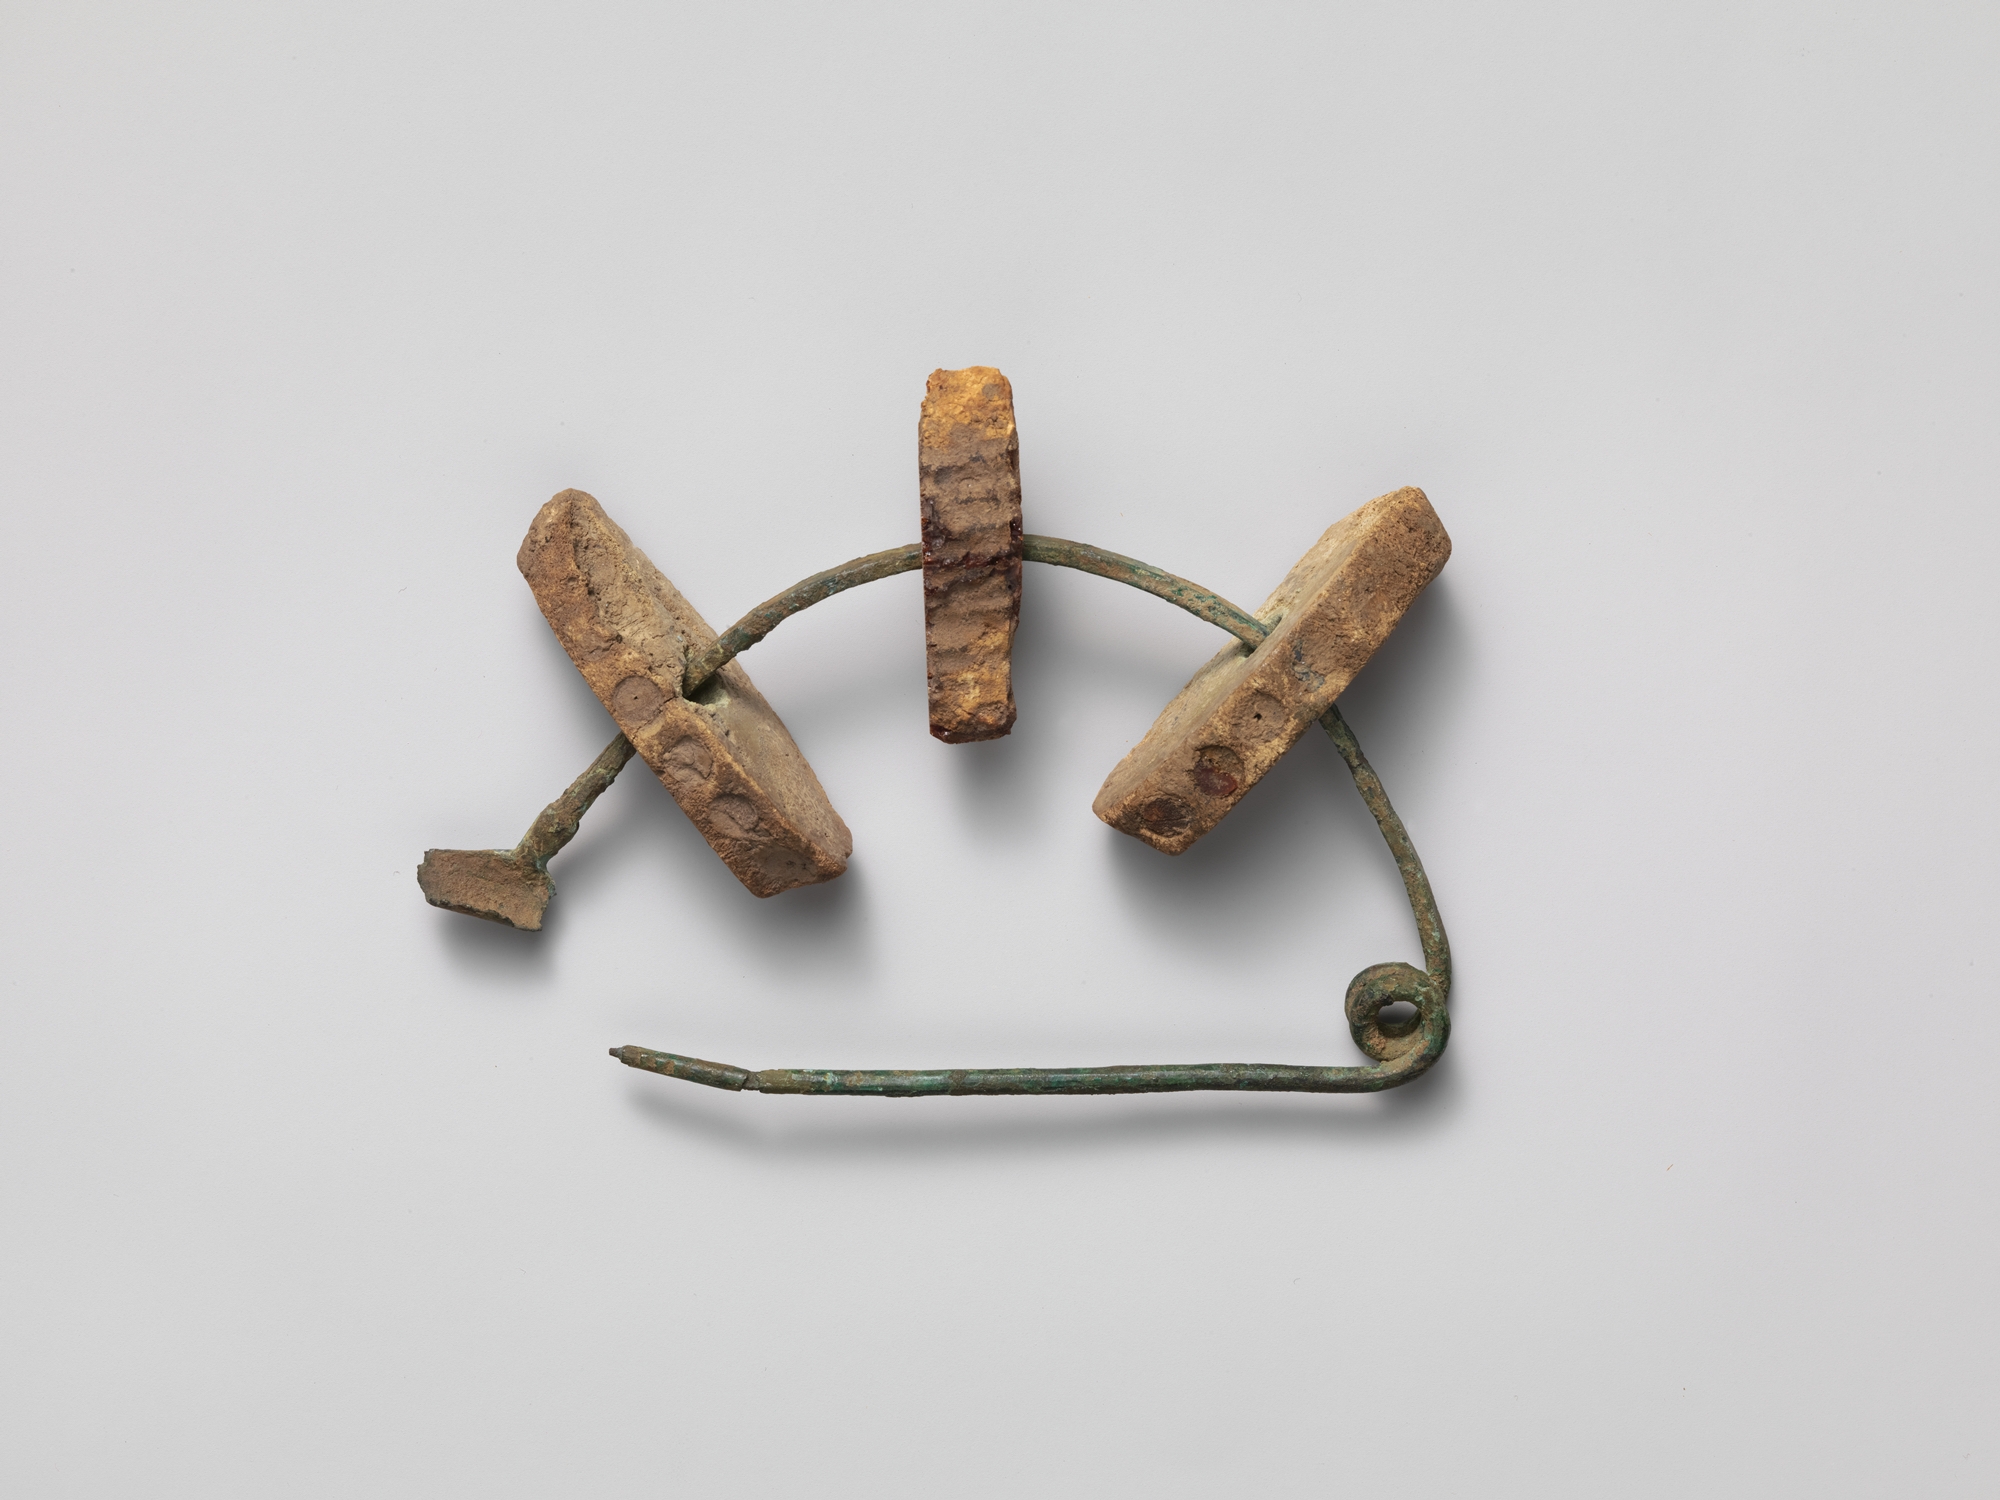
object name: fibula, with amber segment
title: Bronze fibula (safety pin) with amber segments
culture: etruscan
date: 700-501 BCE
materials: amber